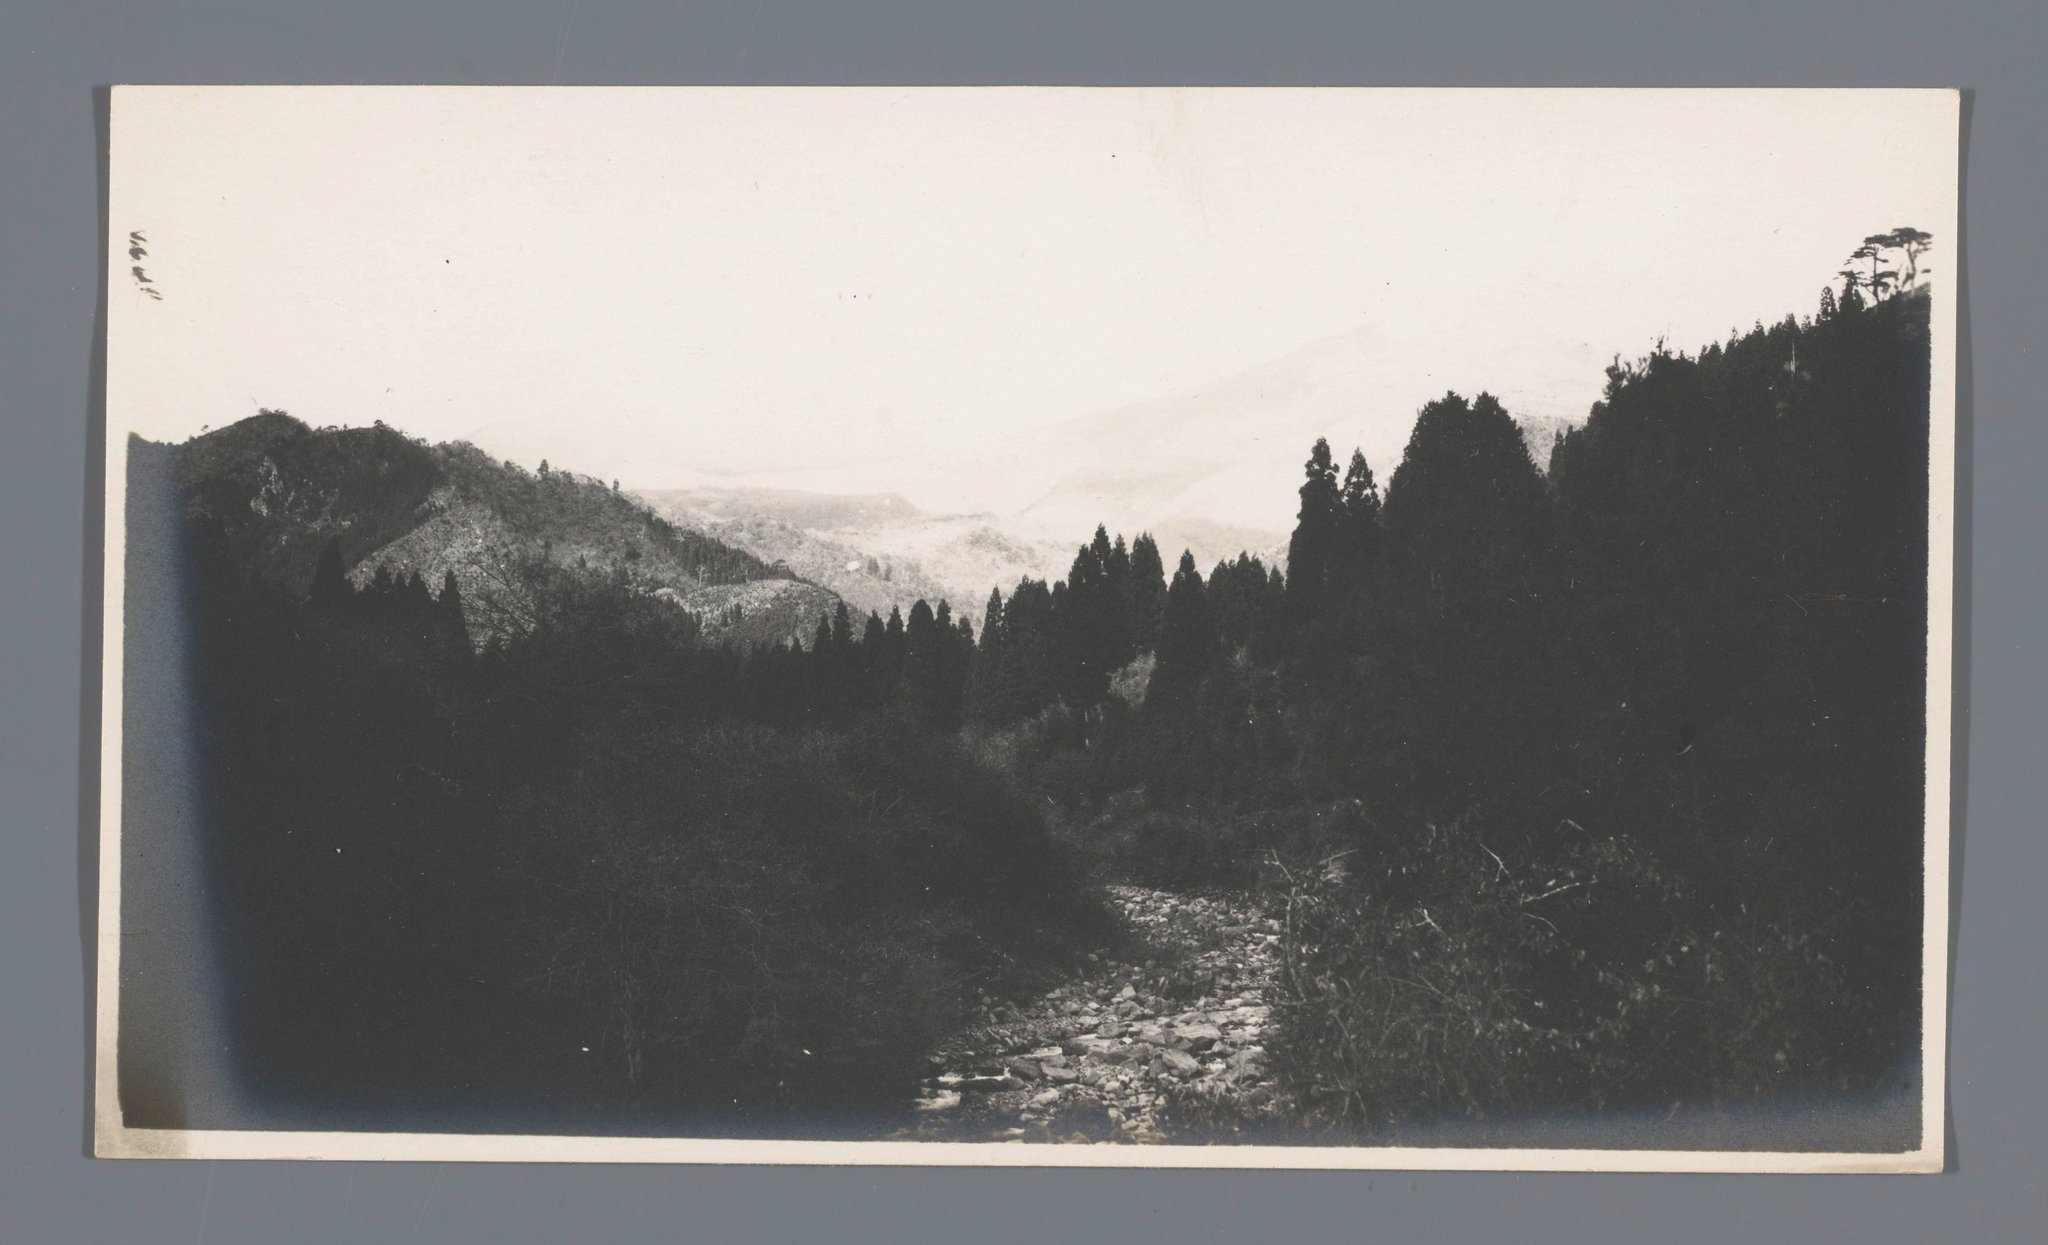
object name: photograph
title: Bergachtig landschap met bossen, Nikko, Japan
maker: jan adriani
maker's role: fotograaf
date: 1907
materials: paper, photographic support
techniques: gelatin silver print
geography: japan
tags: forest, wood, mountains